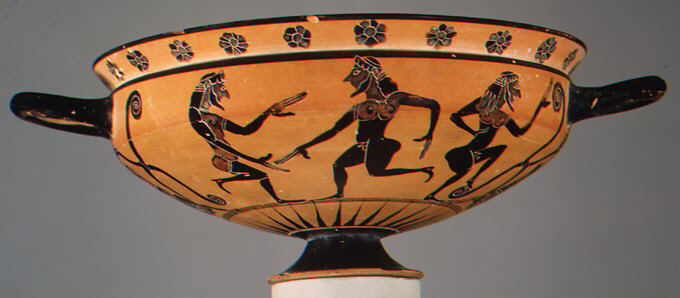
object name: kylix komast cup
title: Terracotta kylix: Komast cup (drinking cup)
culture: greek, attic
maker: kx painter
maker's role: artist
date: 580-570 BCE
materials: terracotta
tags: dancing,dancers